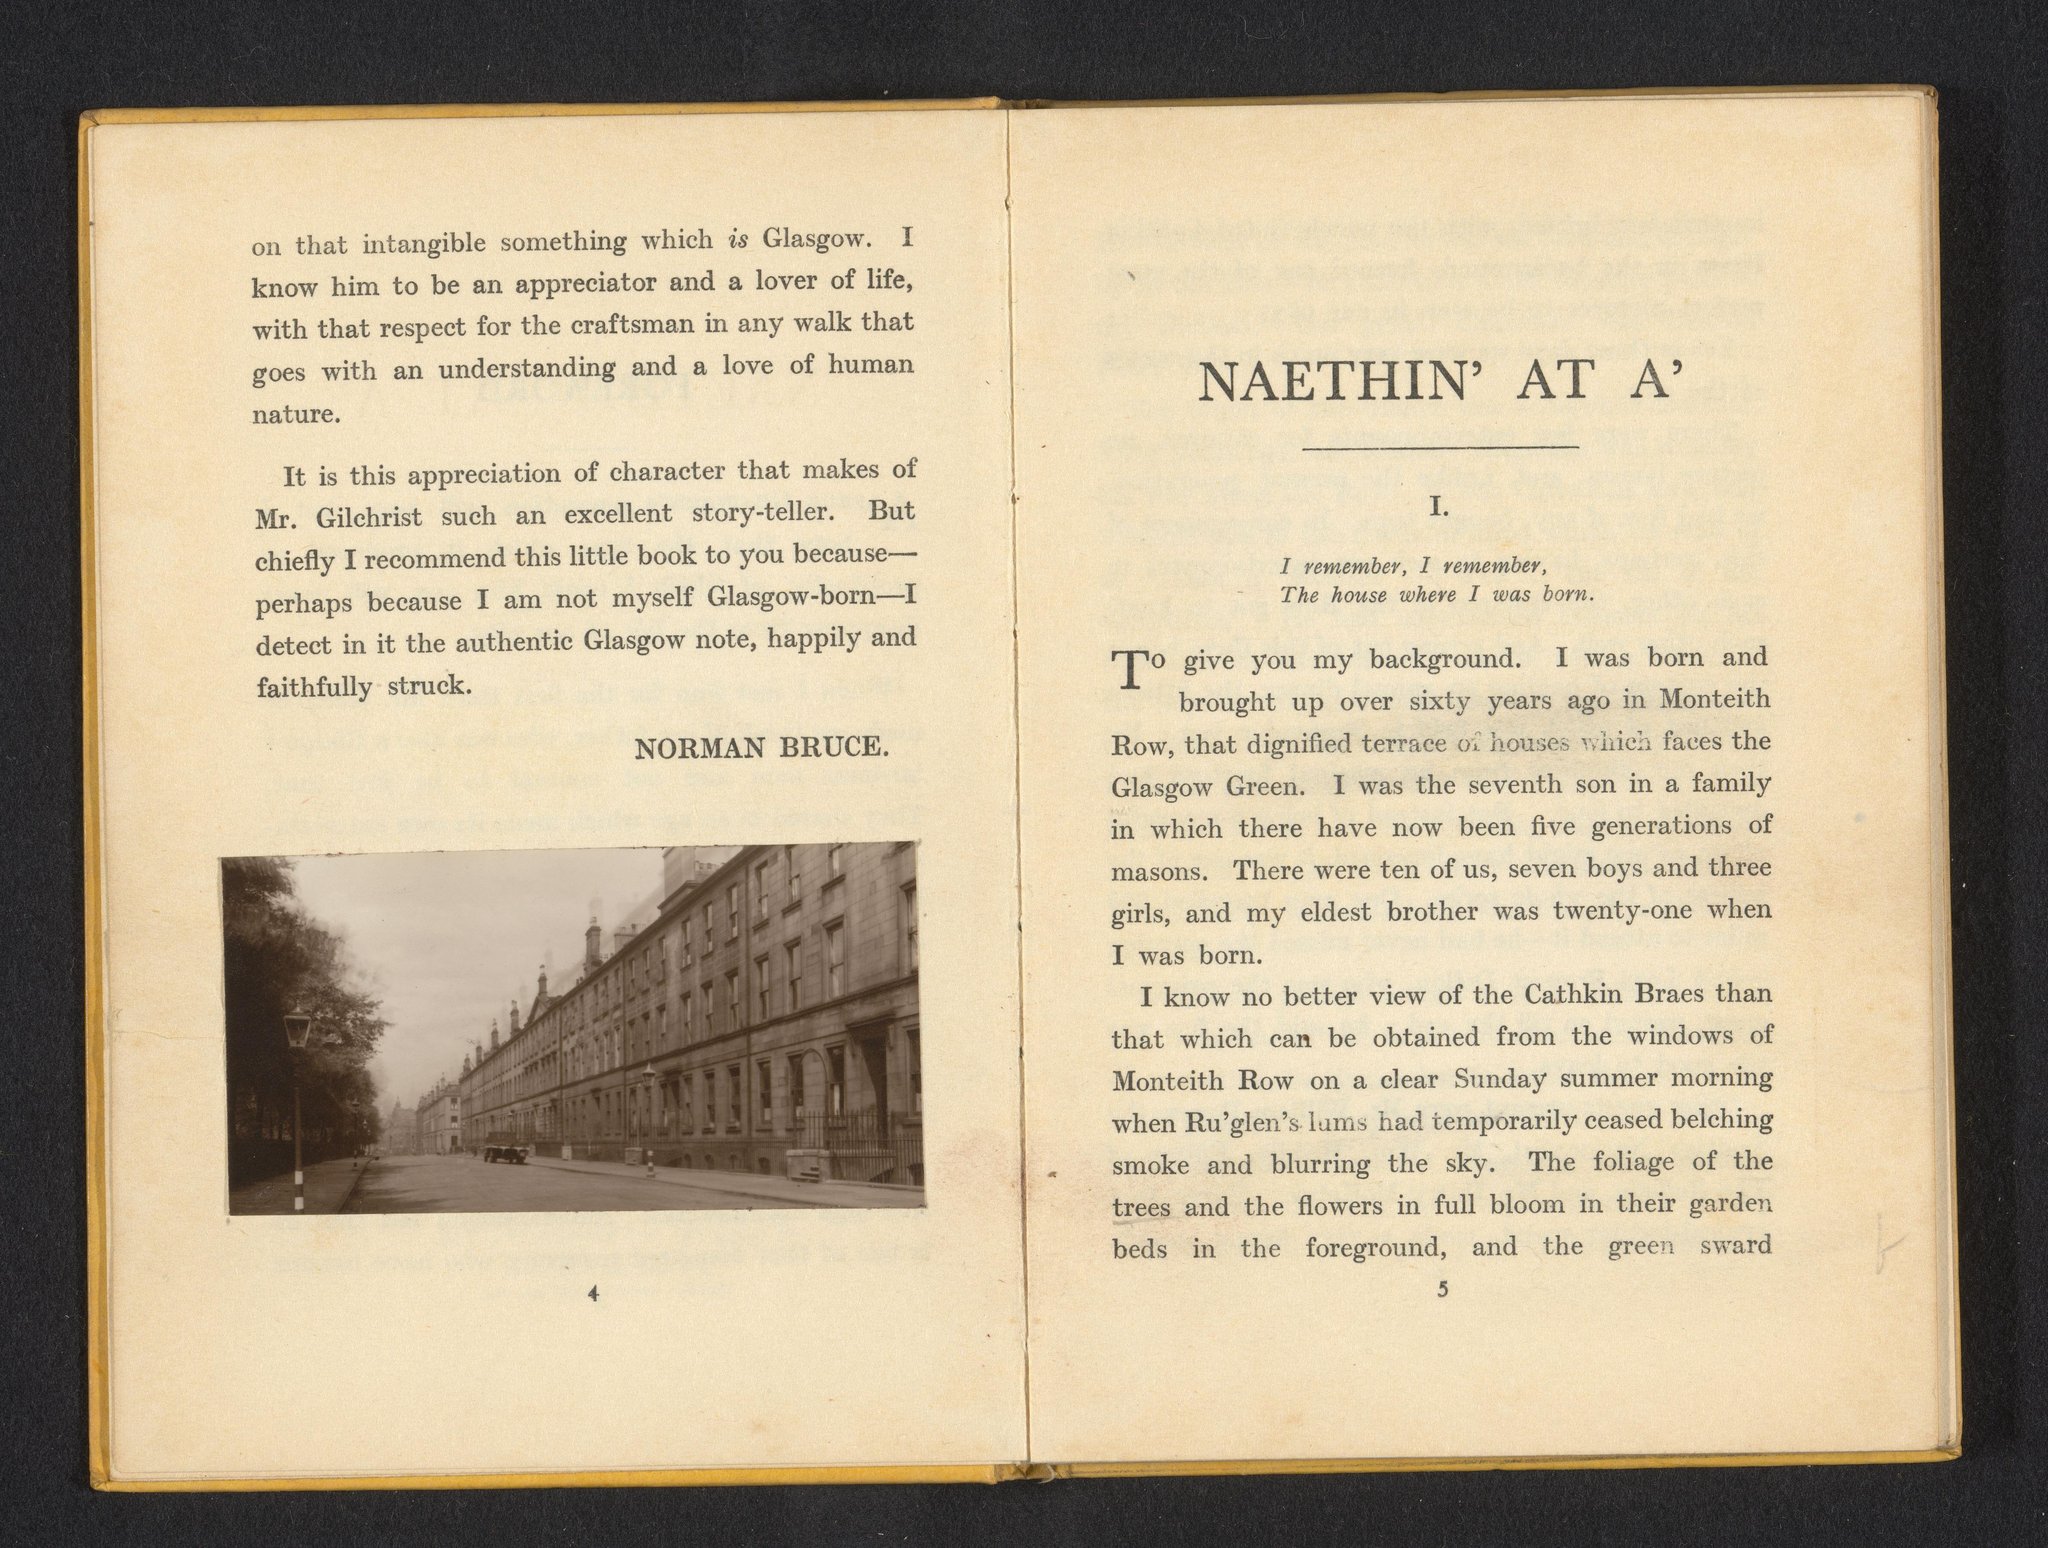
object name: page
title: Gezicht op Monteith Row te Glasgow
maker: Anonymous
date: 1930-1940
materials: photographic support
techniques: gelatin silver print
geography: glasgow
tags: façade (of house or building), street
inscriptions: inscription: ‘Chapter IV: (...) thee-inch collars."’